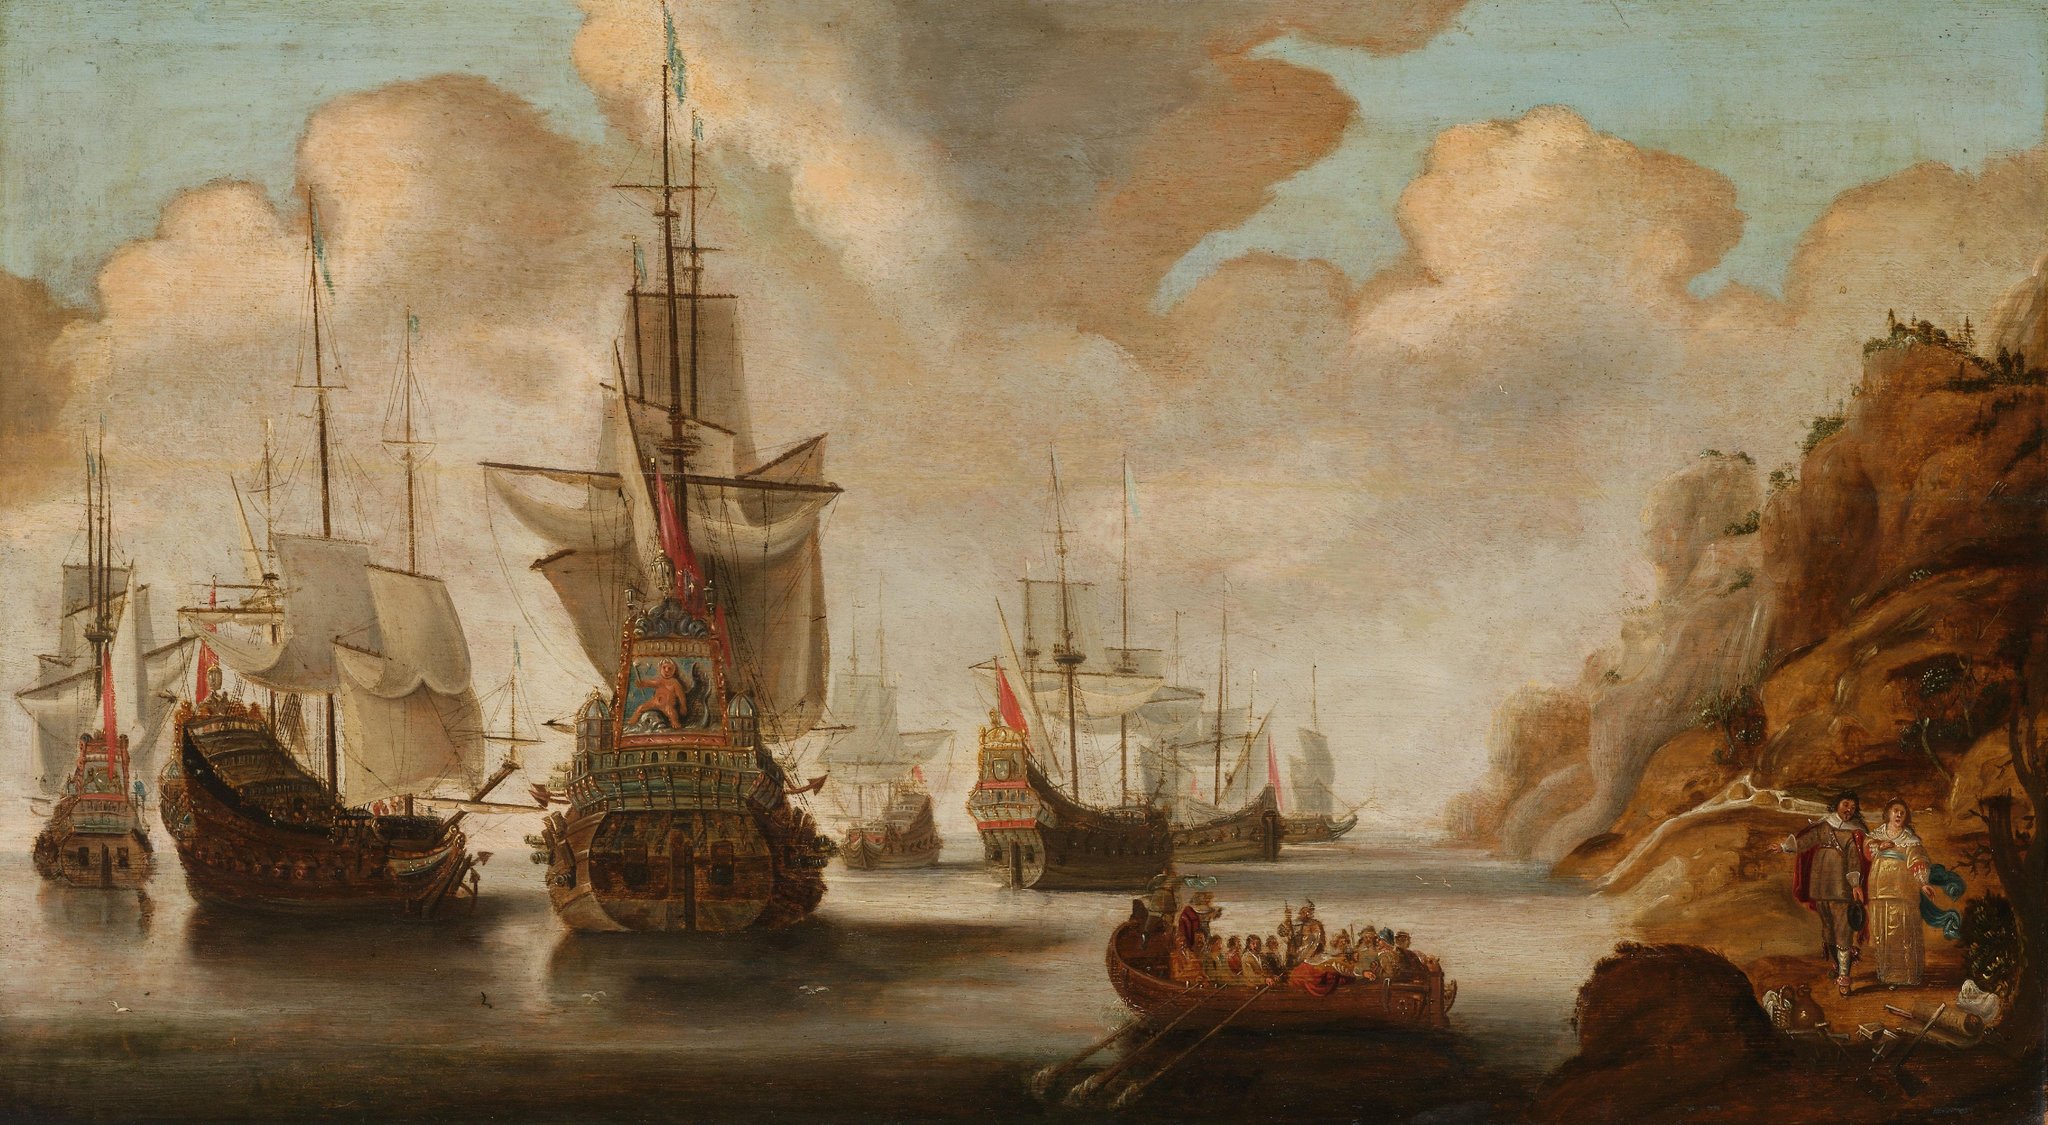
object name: painting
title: A French Squadron near a Rocky Coast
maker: jacob bellevois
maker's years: 1621-1676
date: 1640-1676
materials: oil, panel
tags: sailing-ship, sailing-boat, rocky coast, navy (+ sailing-ships)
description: Een Frans eskader oorlogsschepen bij een rotsachtige kust. Een sloep roeit vanaf de schepen naar de kust. Vergelijk een identieke voorstelling SK-A-4248.